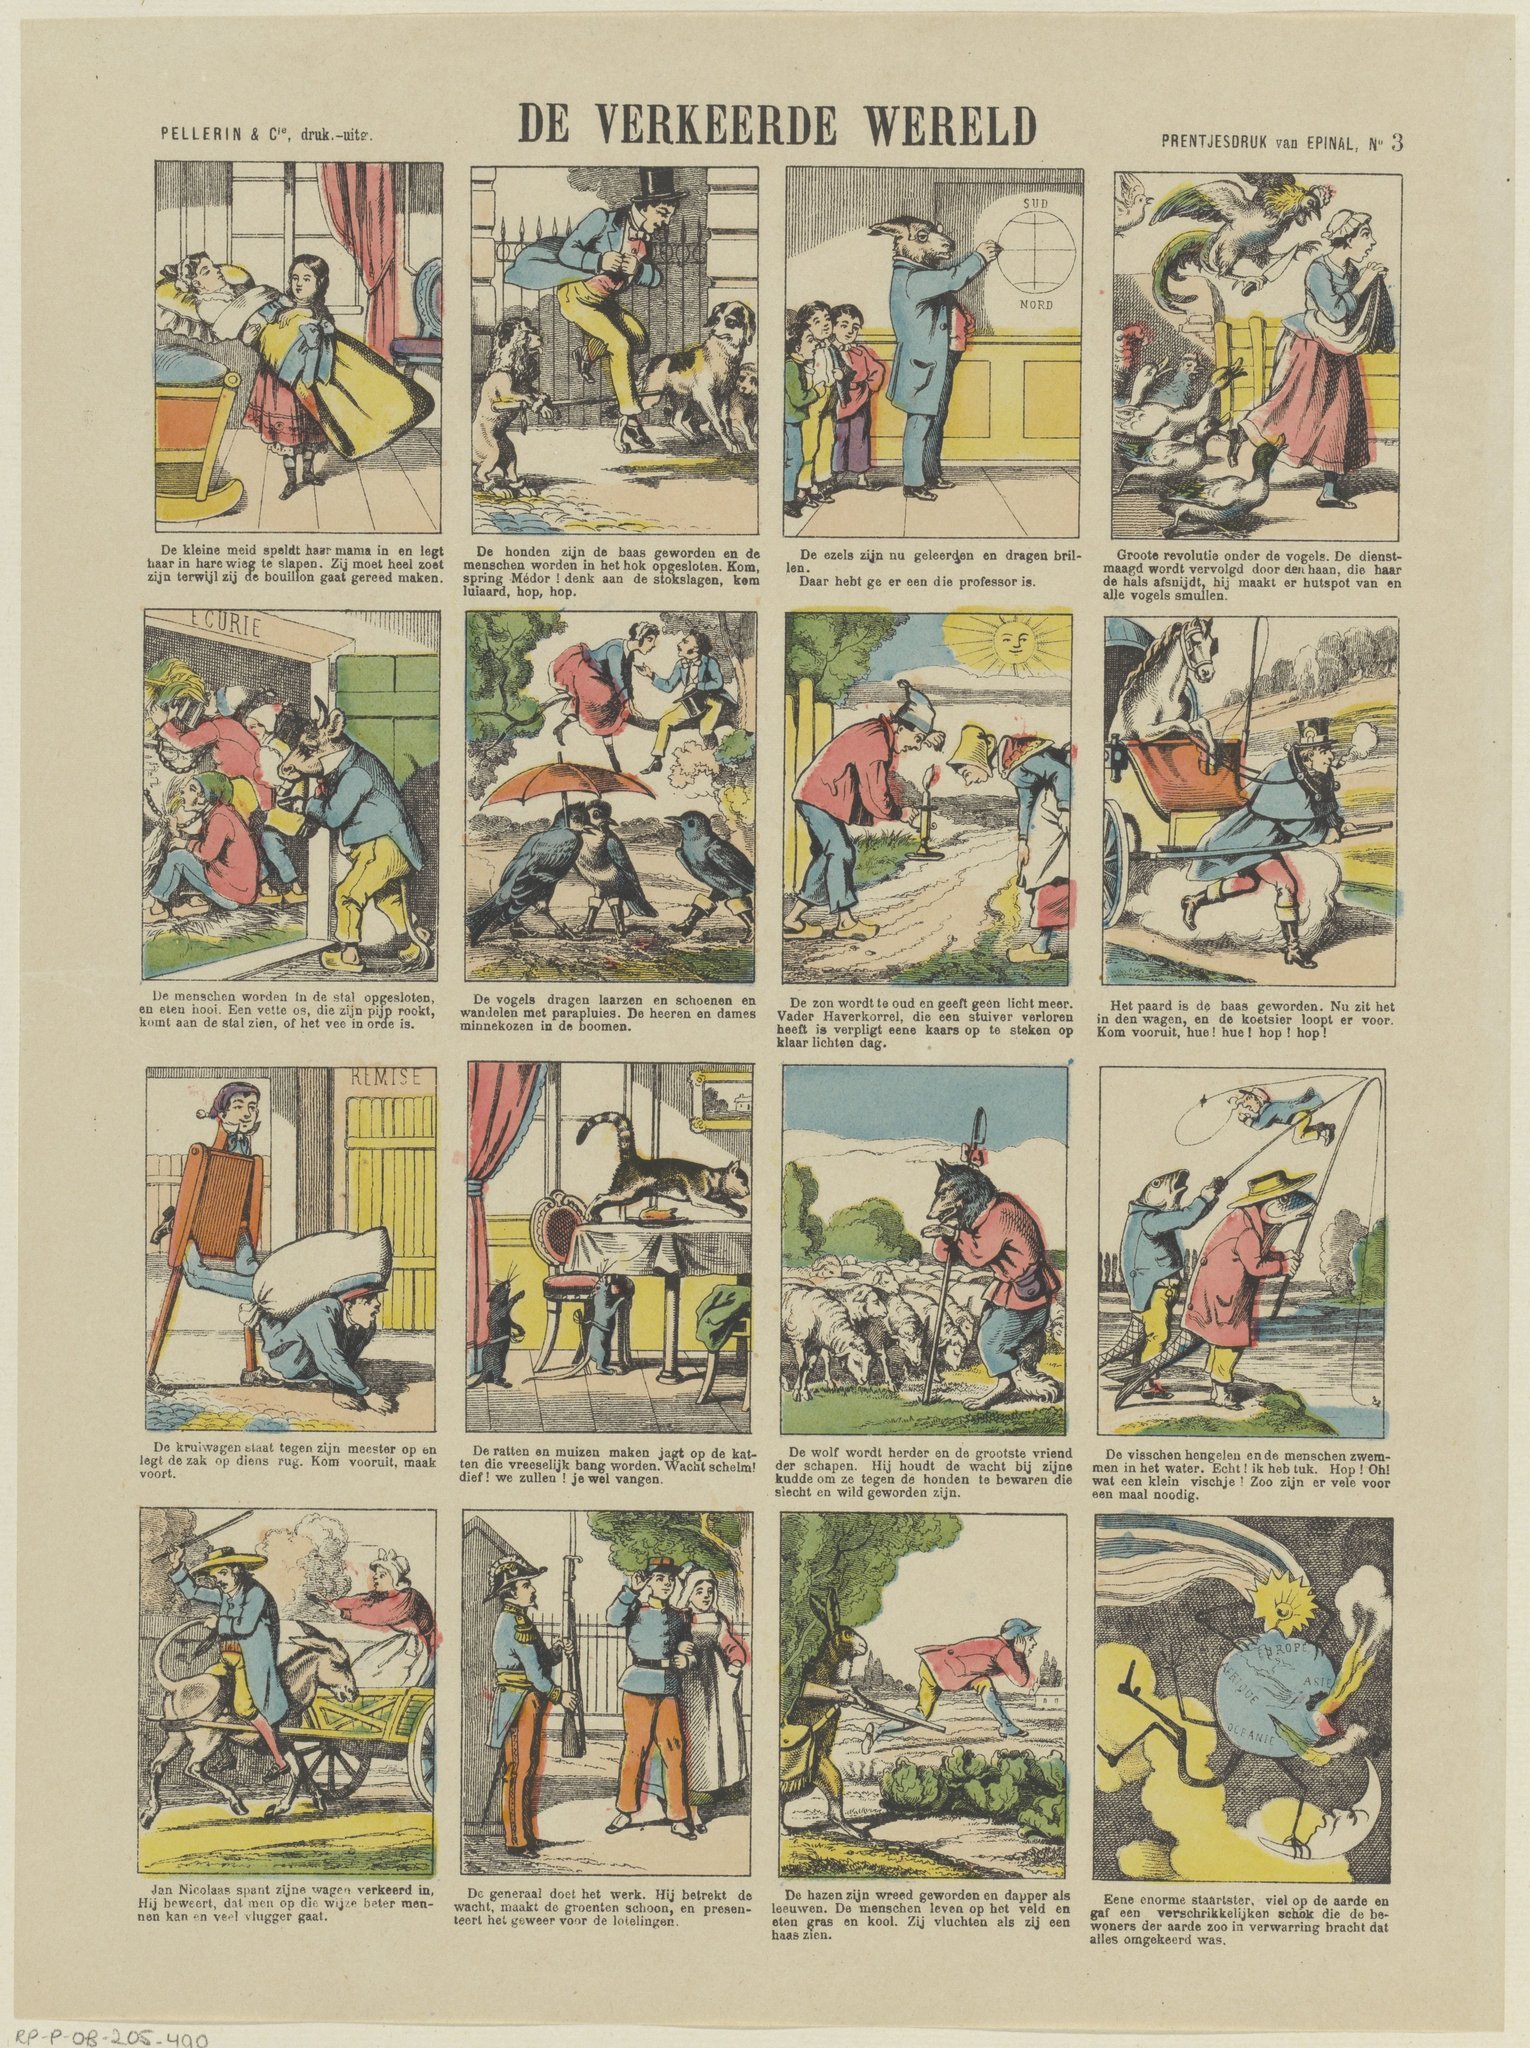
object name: popular print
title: De verkeerde wereld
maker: Anonymous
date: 1902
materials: paper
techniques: colour, letterpress printing, lithograph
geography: epinal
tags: 'mundus inversus', the reversed world, the topsy-turvy world, 'le monde bestourné', animals acting as human beings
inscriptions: collector's mark: Lugt 2760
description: Blad met 16 voorstellingen van de verkeerde wereld, waar onder andere dieren zich als mensen gedragen. Onder elke afbeelding een onderschrift. Genummerd rechtsboven: No 3.